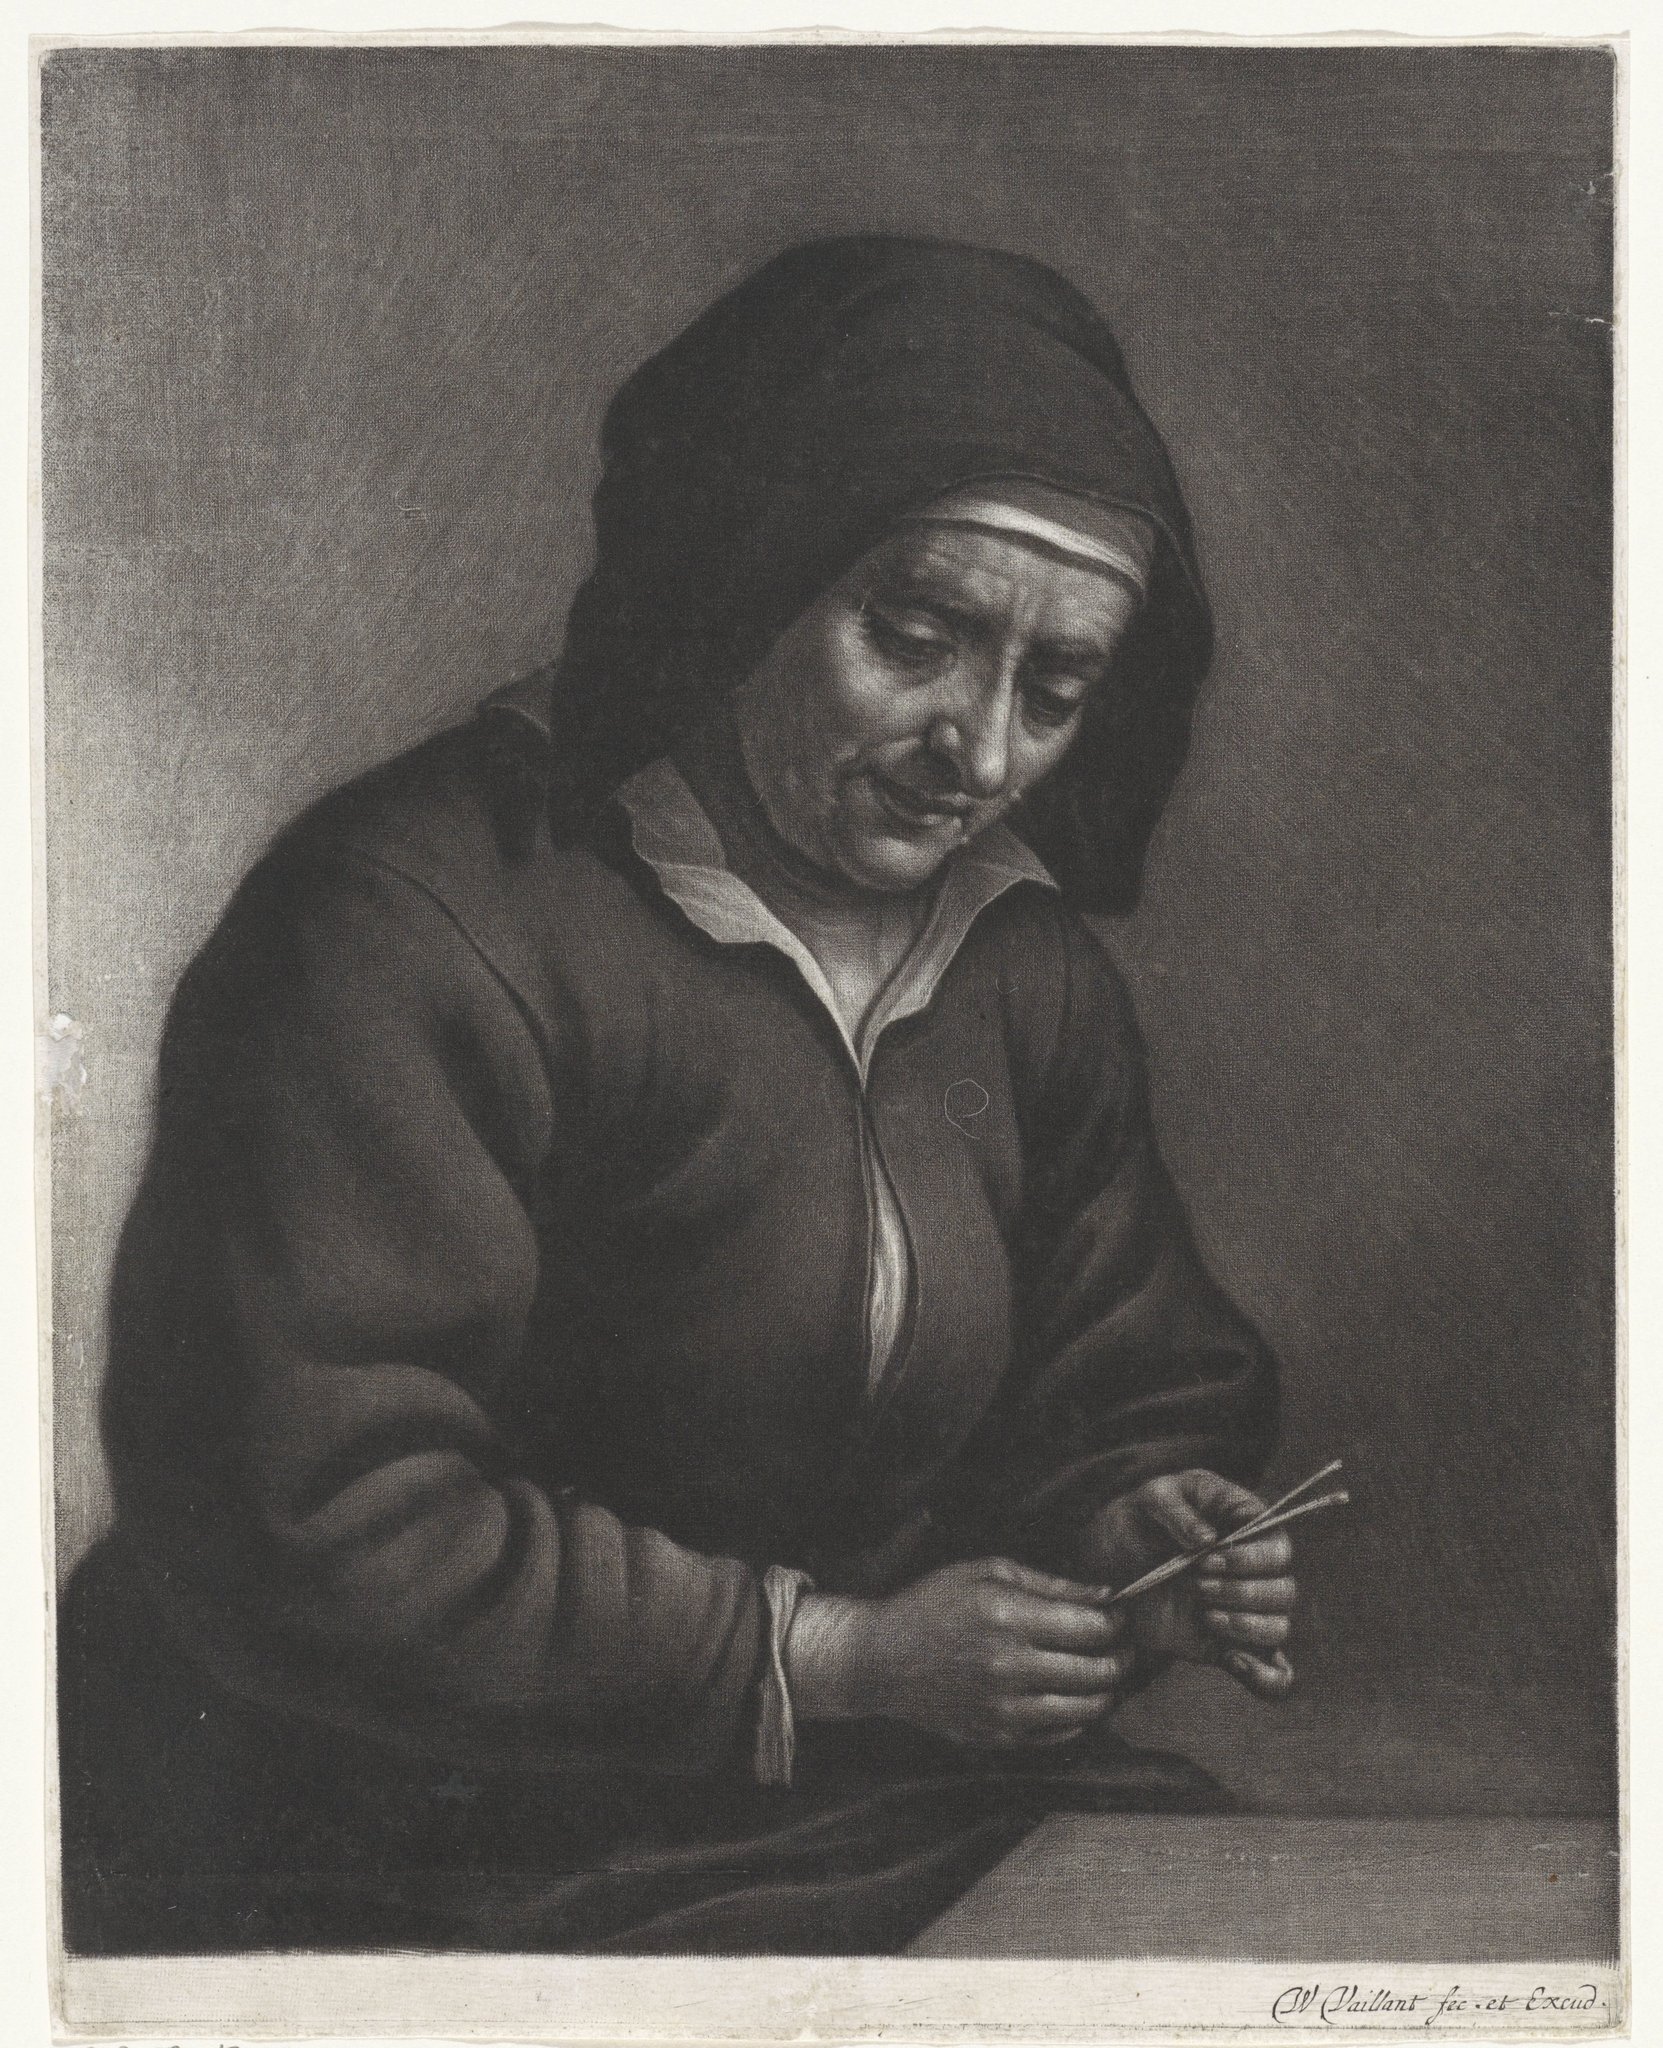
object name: print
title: Vrouw aan een tafel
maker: wallerant vaillant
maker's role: draughtsman, painter, print maker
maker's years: 1623-1677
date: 1658-1677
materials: paper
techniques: mezzotint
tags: old woman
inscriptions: collector's mark: Lugt 240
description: Deze prent is de pendant van Hollstein nr. 84 van dezelfde prentmaker.